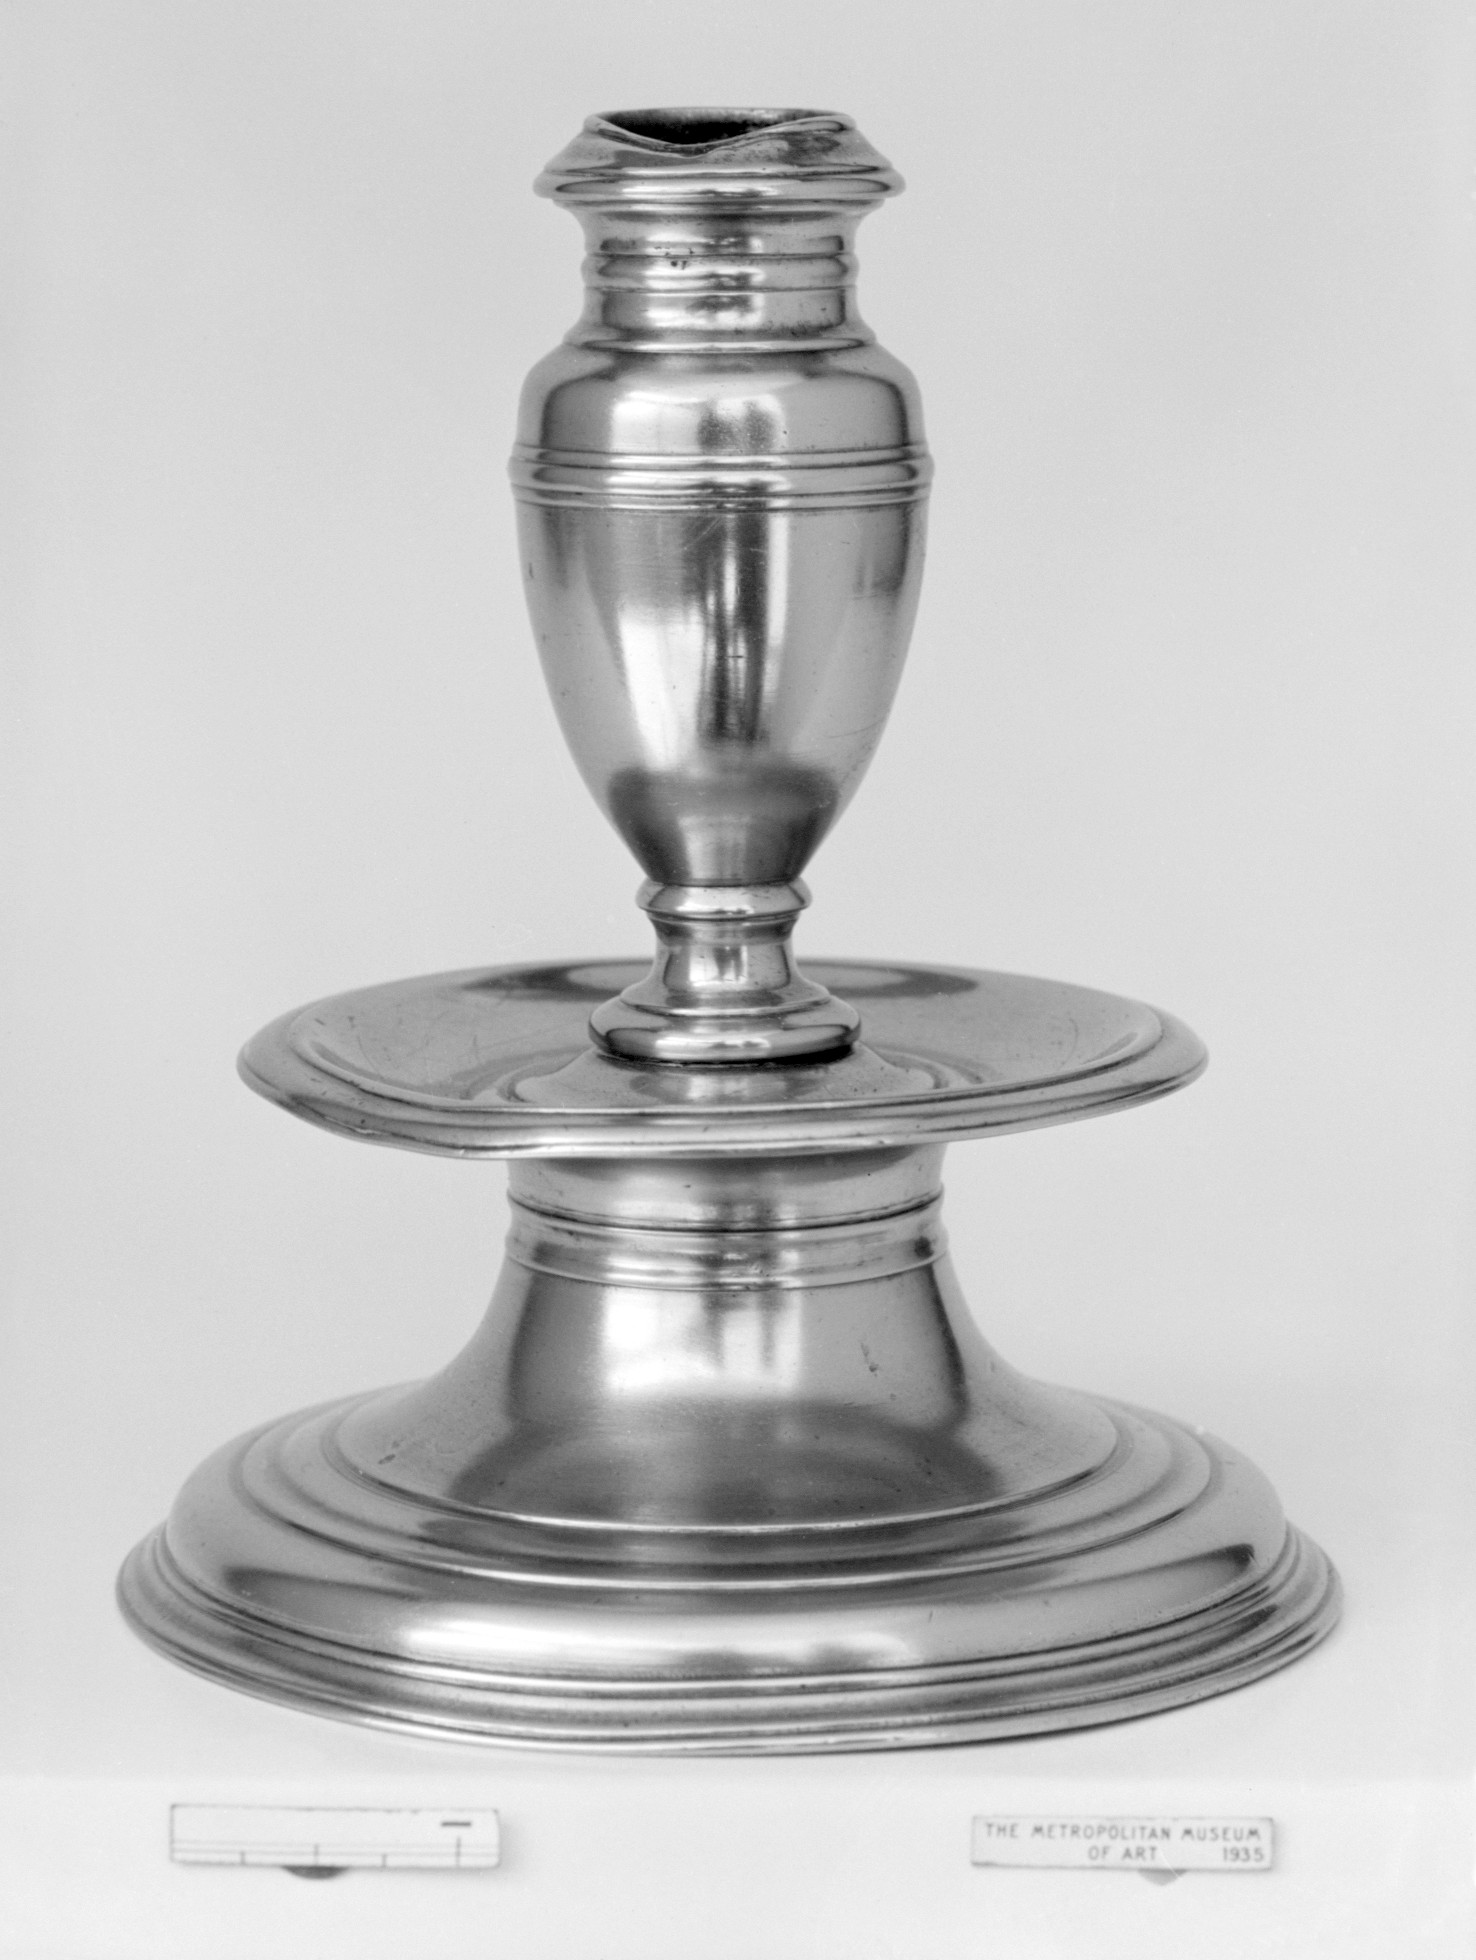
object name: candlestick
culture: british or flemish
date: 1630-1670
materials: brass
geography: belgium